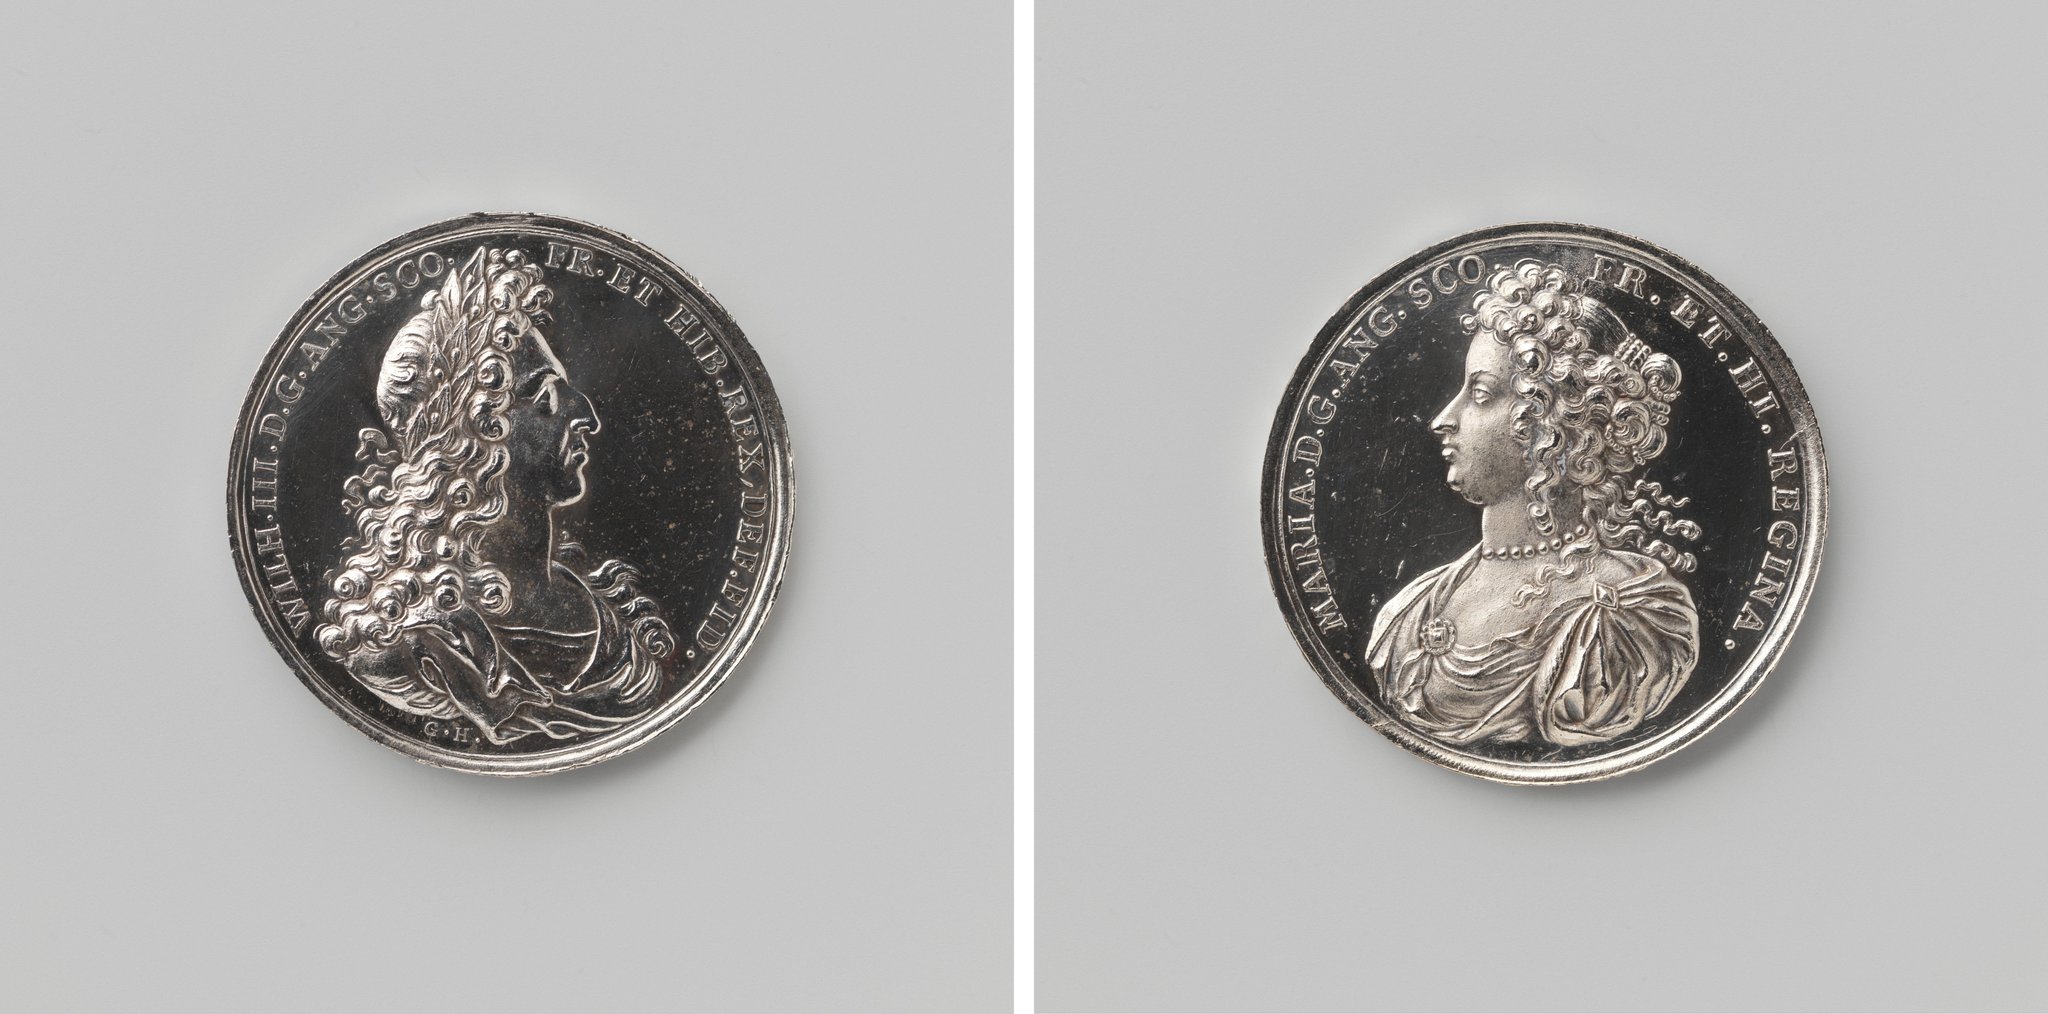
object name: history medal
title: Kroning van Willem III en Maria II Stuart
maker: georg hautsch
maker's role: medailleur, muntmaker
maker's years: 1679-1745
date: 1689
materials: silver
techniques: striking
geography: nuremberg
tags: the hague, william iii (prince of orange and king of england, scotland, and ireland), london, maria ii stuart (koningin van engeland, schotland en ierland)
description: Zilveren penning. Voorzijde: borststuk man met lauwerkrans binnen omschrift. Keerzijde: borststuk vrouw binnen omschrift; randschrift